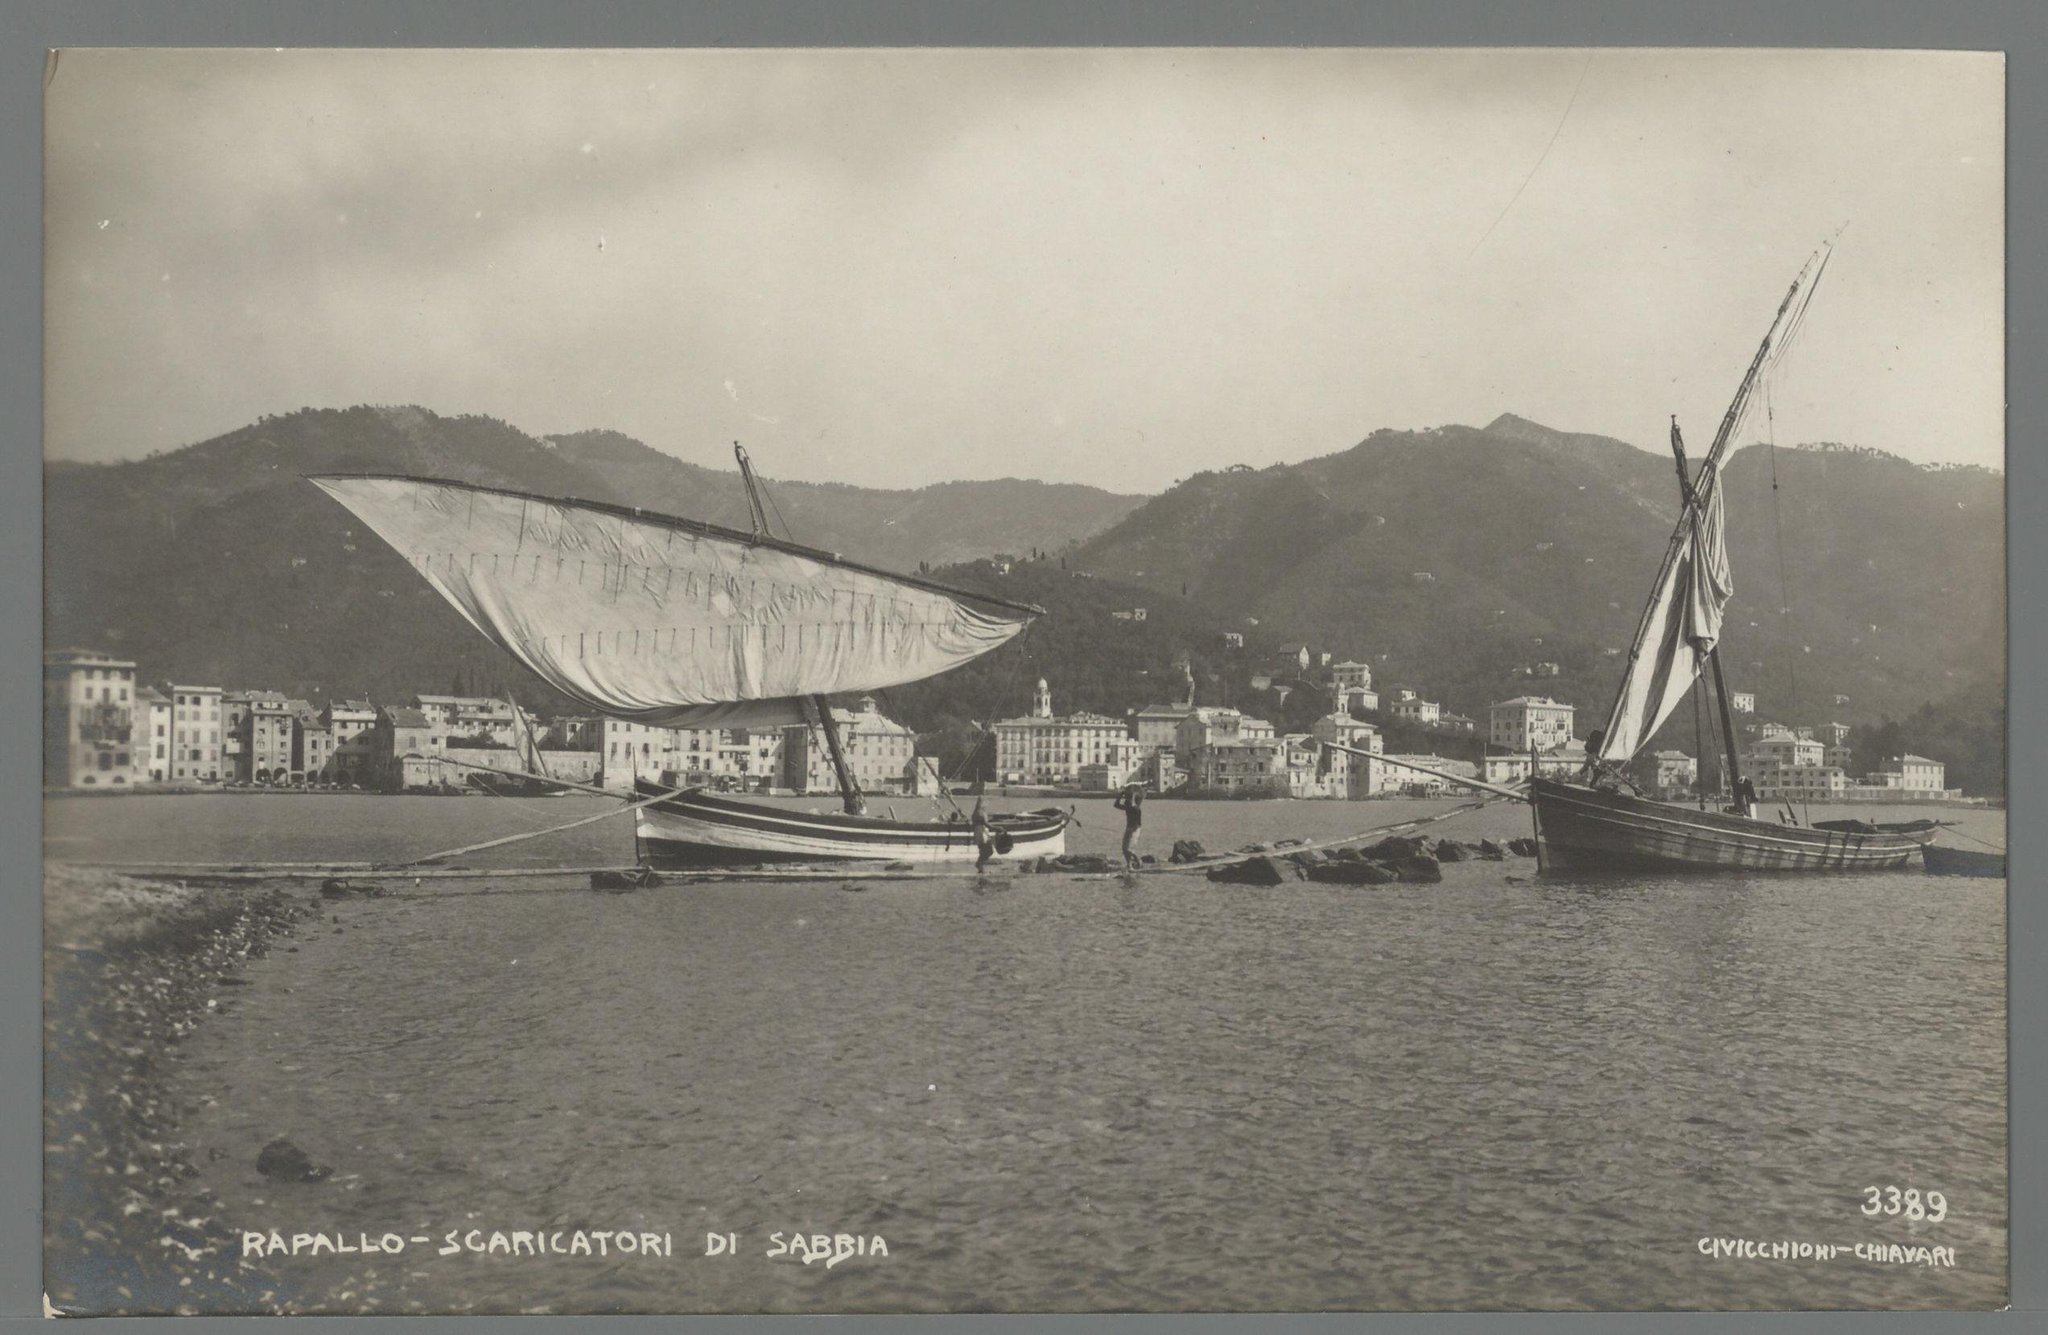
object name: ansichtkaart, prentbriefkaart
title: Rapallo. Scaricatori di Sabbia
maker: Anonymous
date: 1906-1909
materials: photographic support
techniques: photography, writing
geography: rapallo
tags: sailing-ship, sailing-boat, sea (seascape) (+ landscape with figures, staffage)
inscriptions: mark